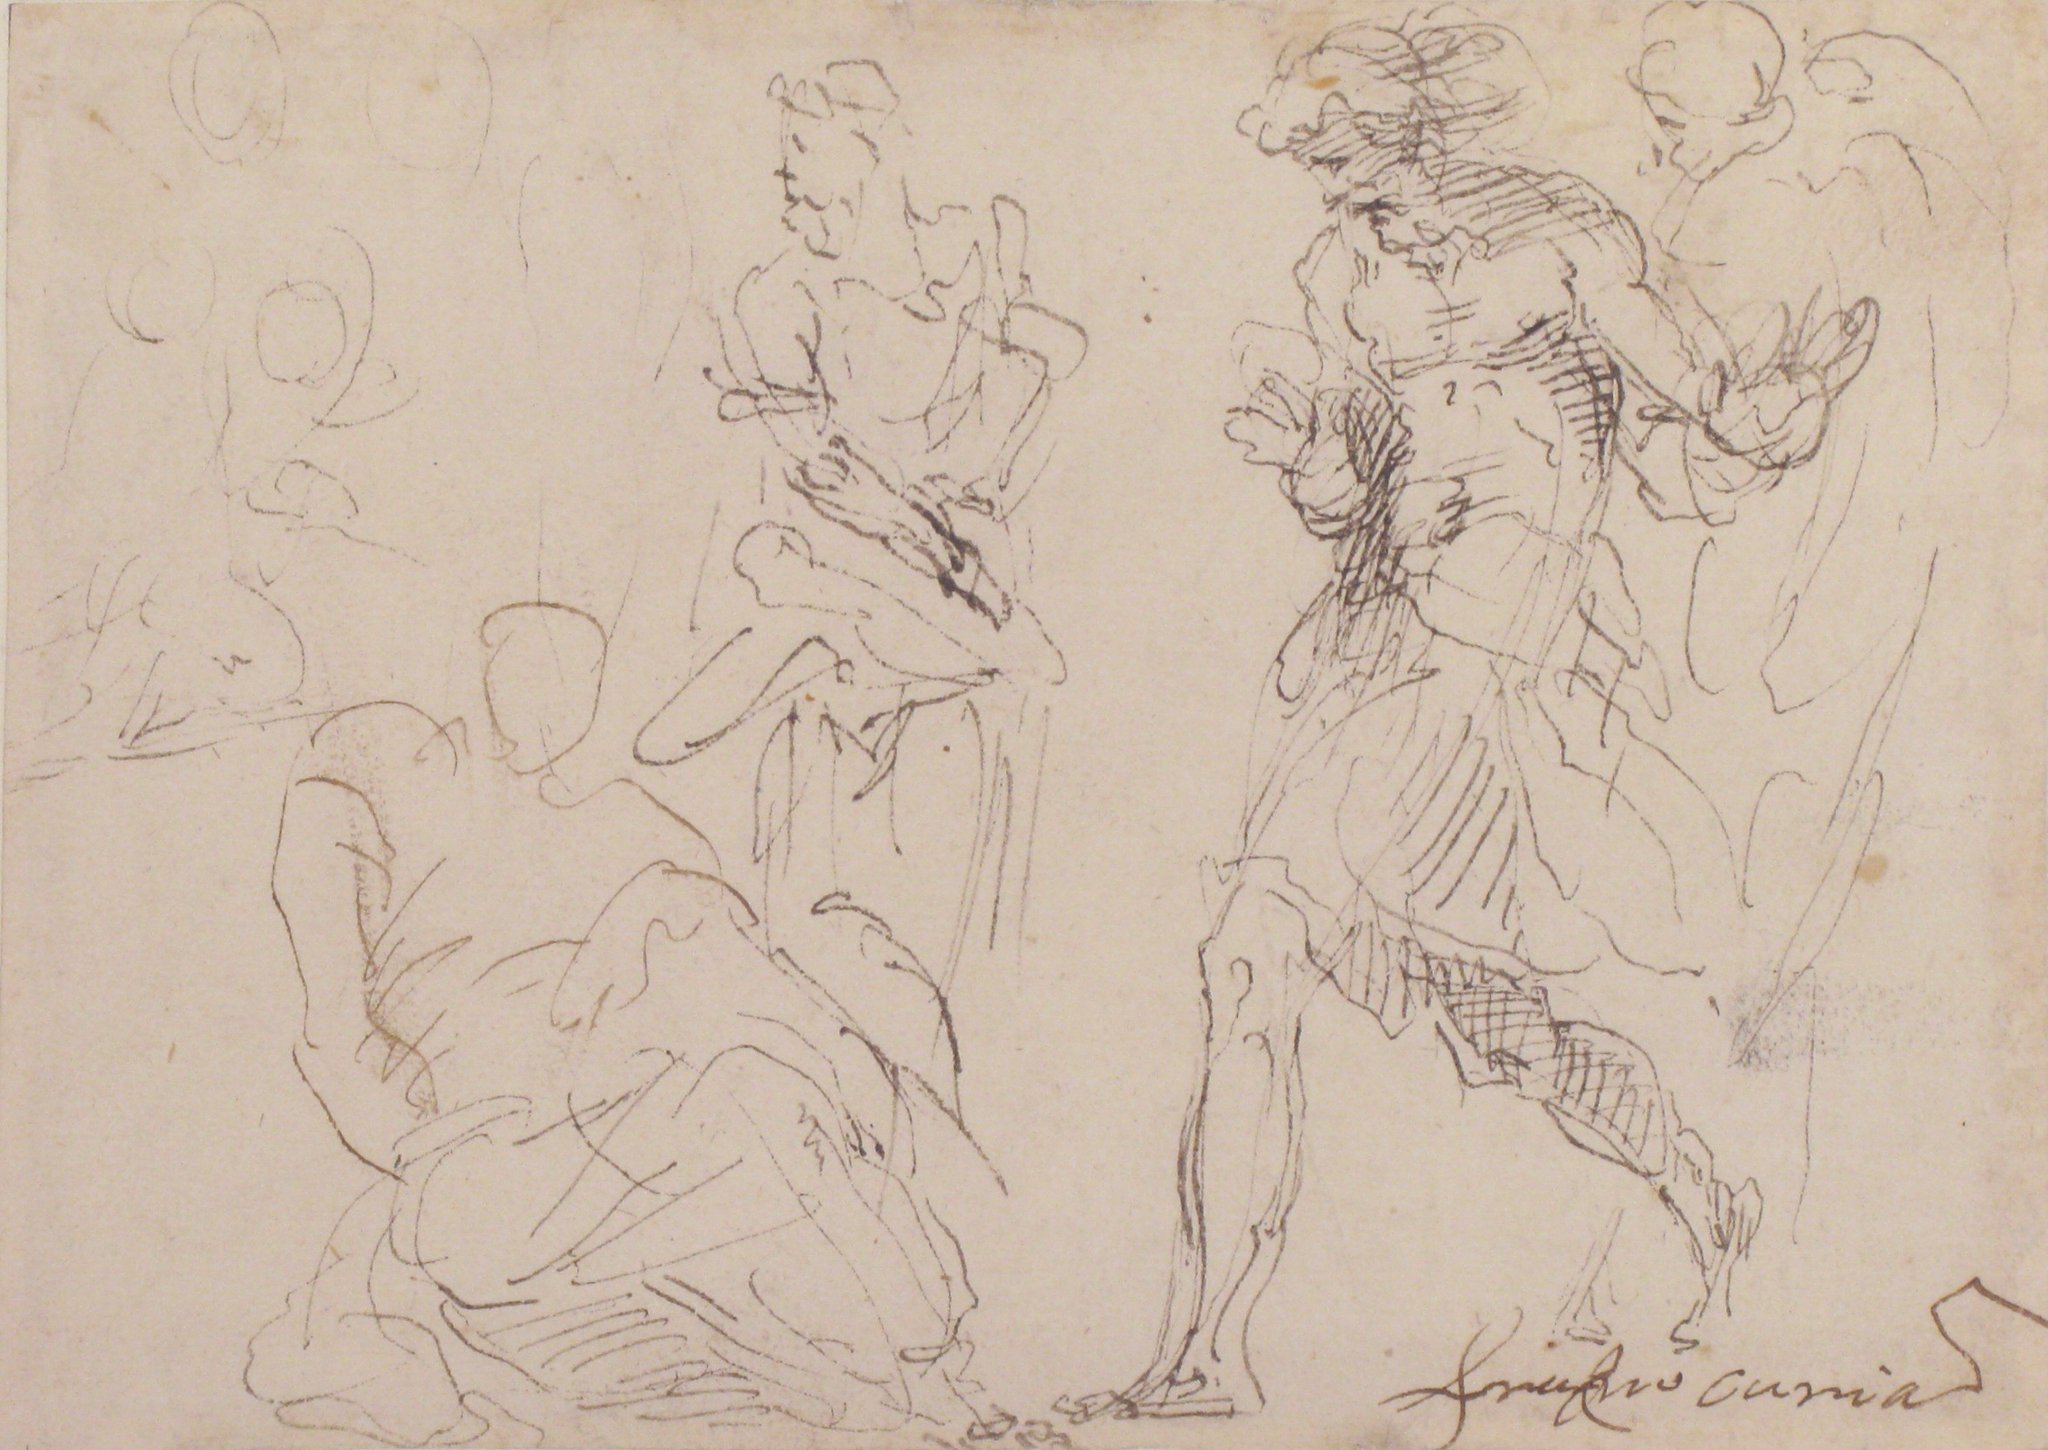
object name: drawing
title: Standing and Seated Figures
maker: francesco curia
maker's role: artist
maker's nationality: italian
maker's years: 1565-1608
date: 1565-1608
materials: ink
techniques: pen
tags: human figures